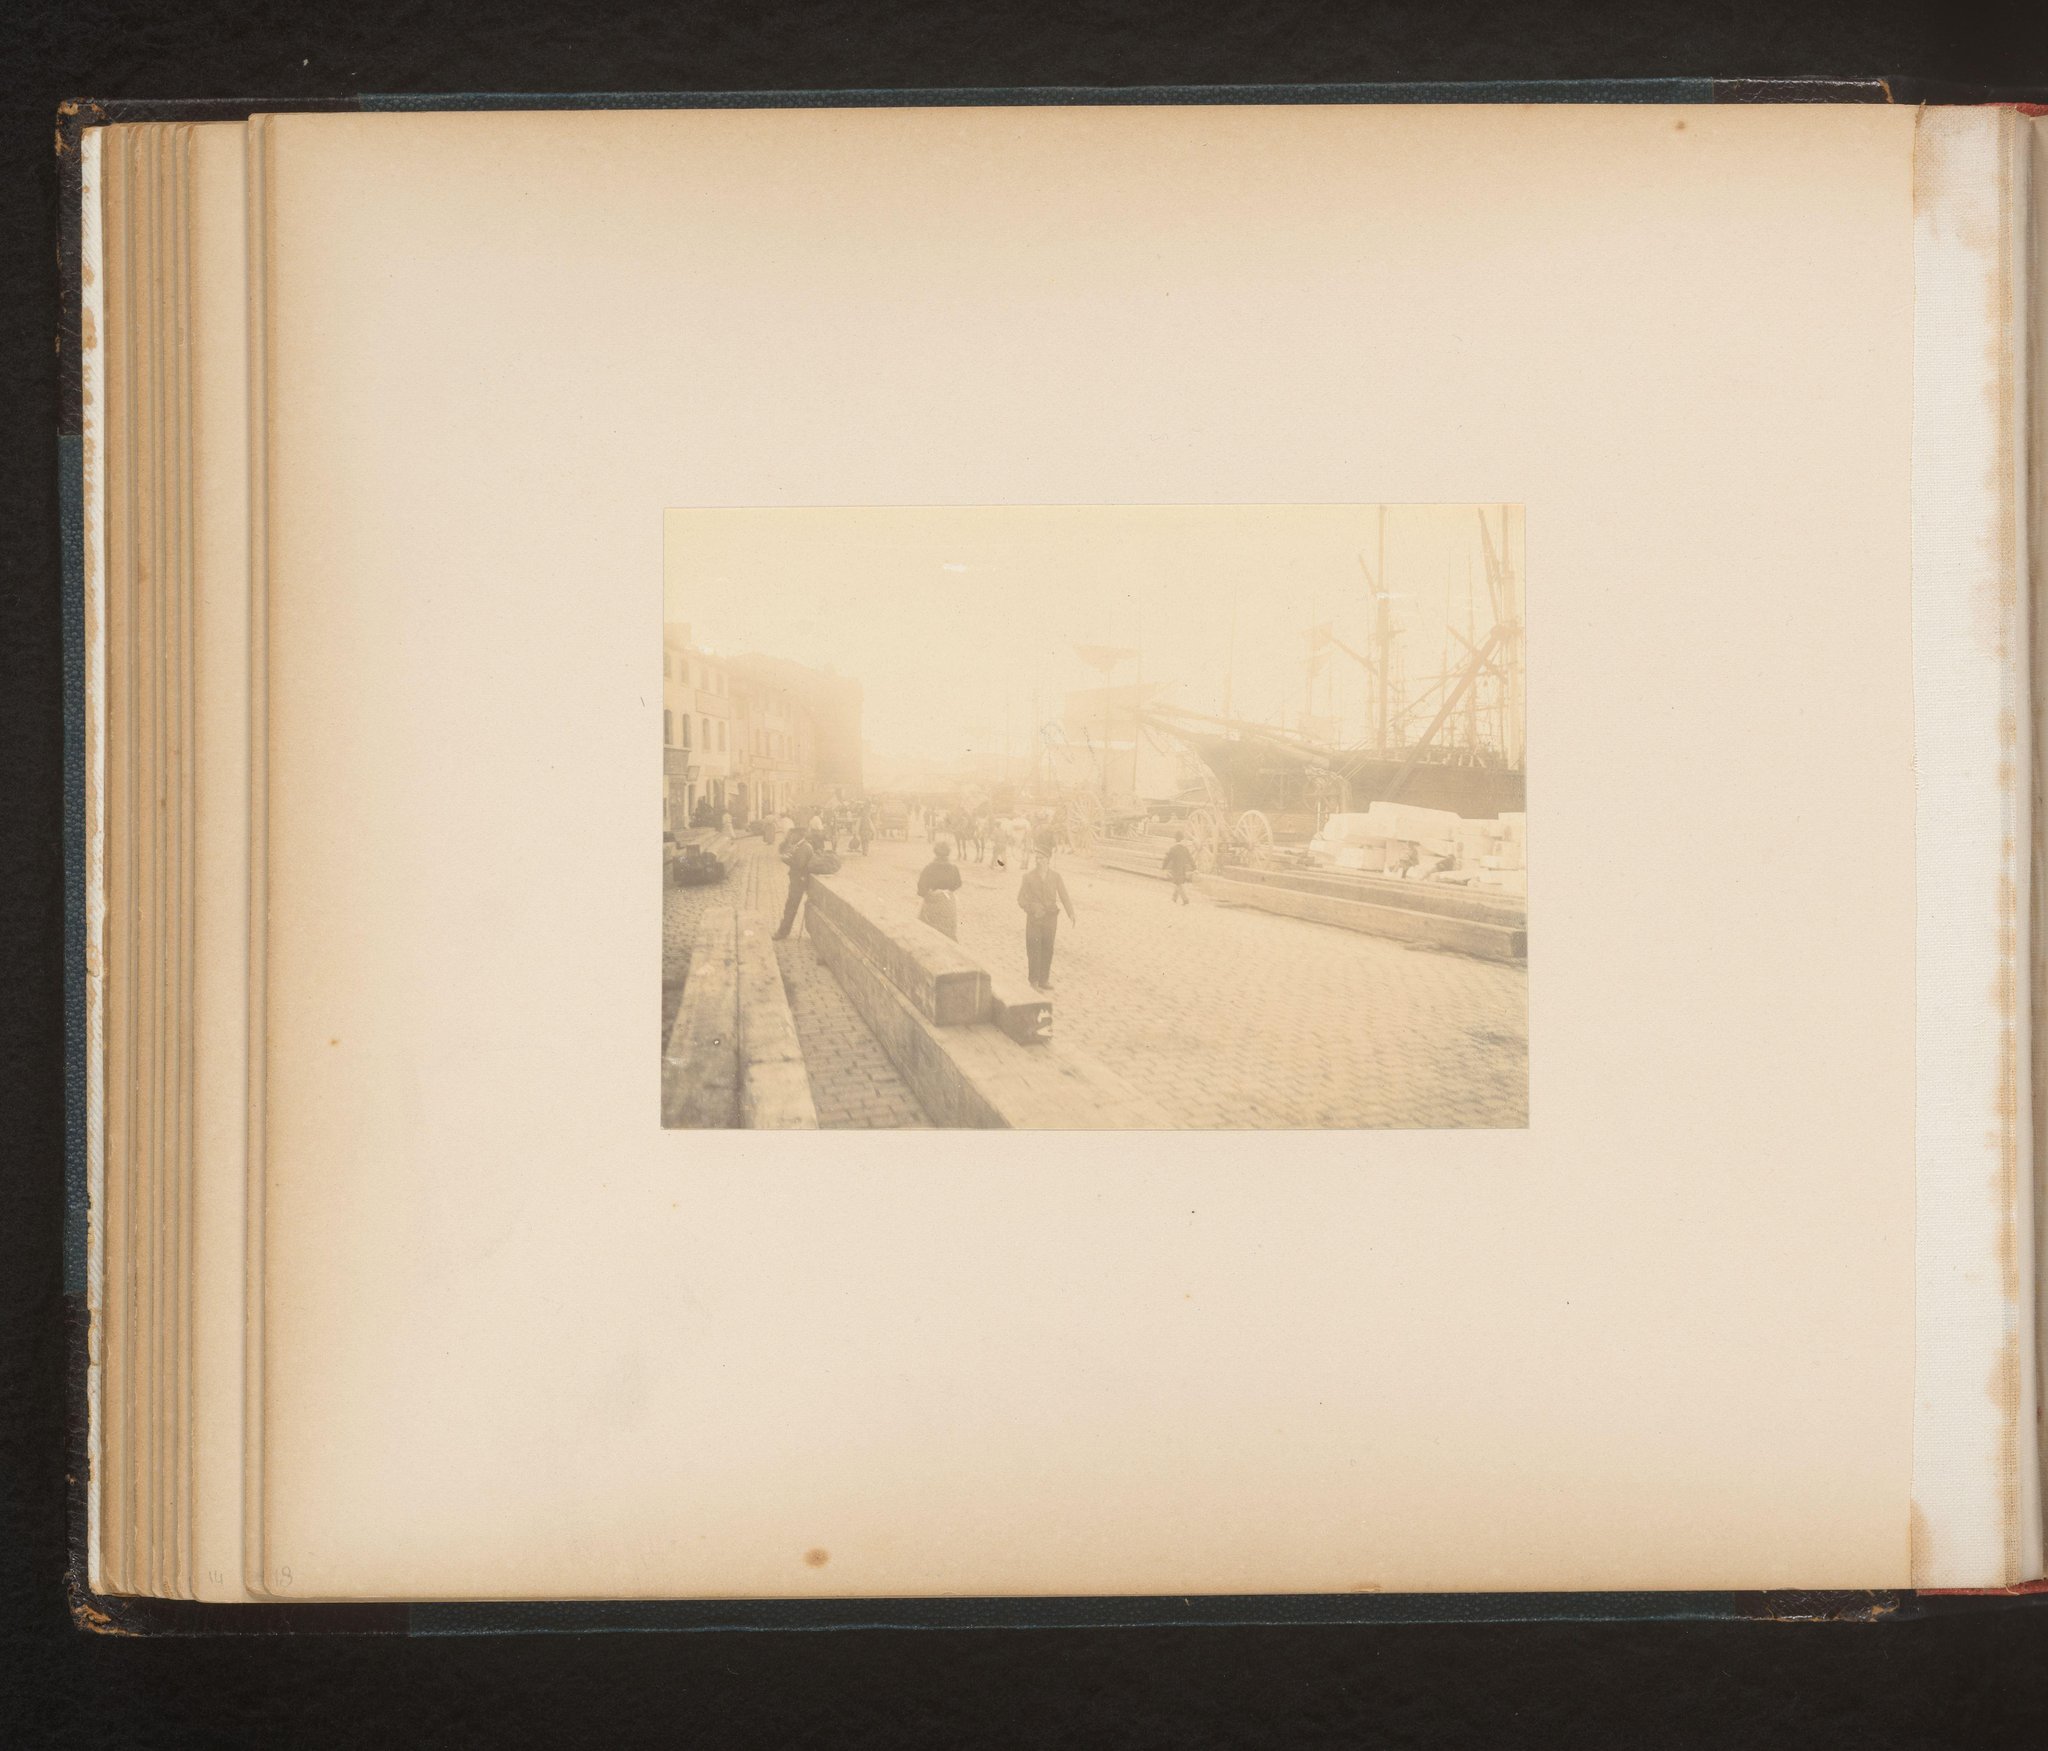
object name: album leaf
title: Gezicht op een kade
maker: Anonymous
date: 1880-1920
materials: cardboard, photographic support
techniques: gelatin silver print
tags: harbour, historical persons, ships (in general), pier, quay, wharf, france